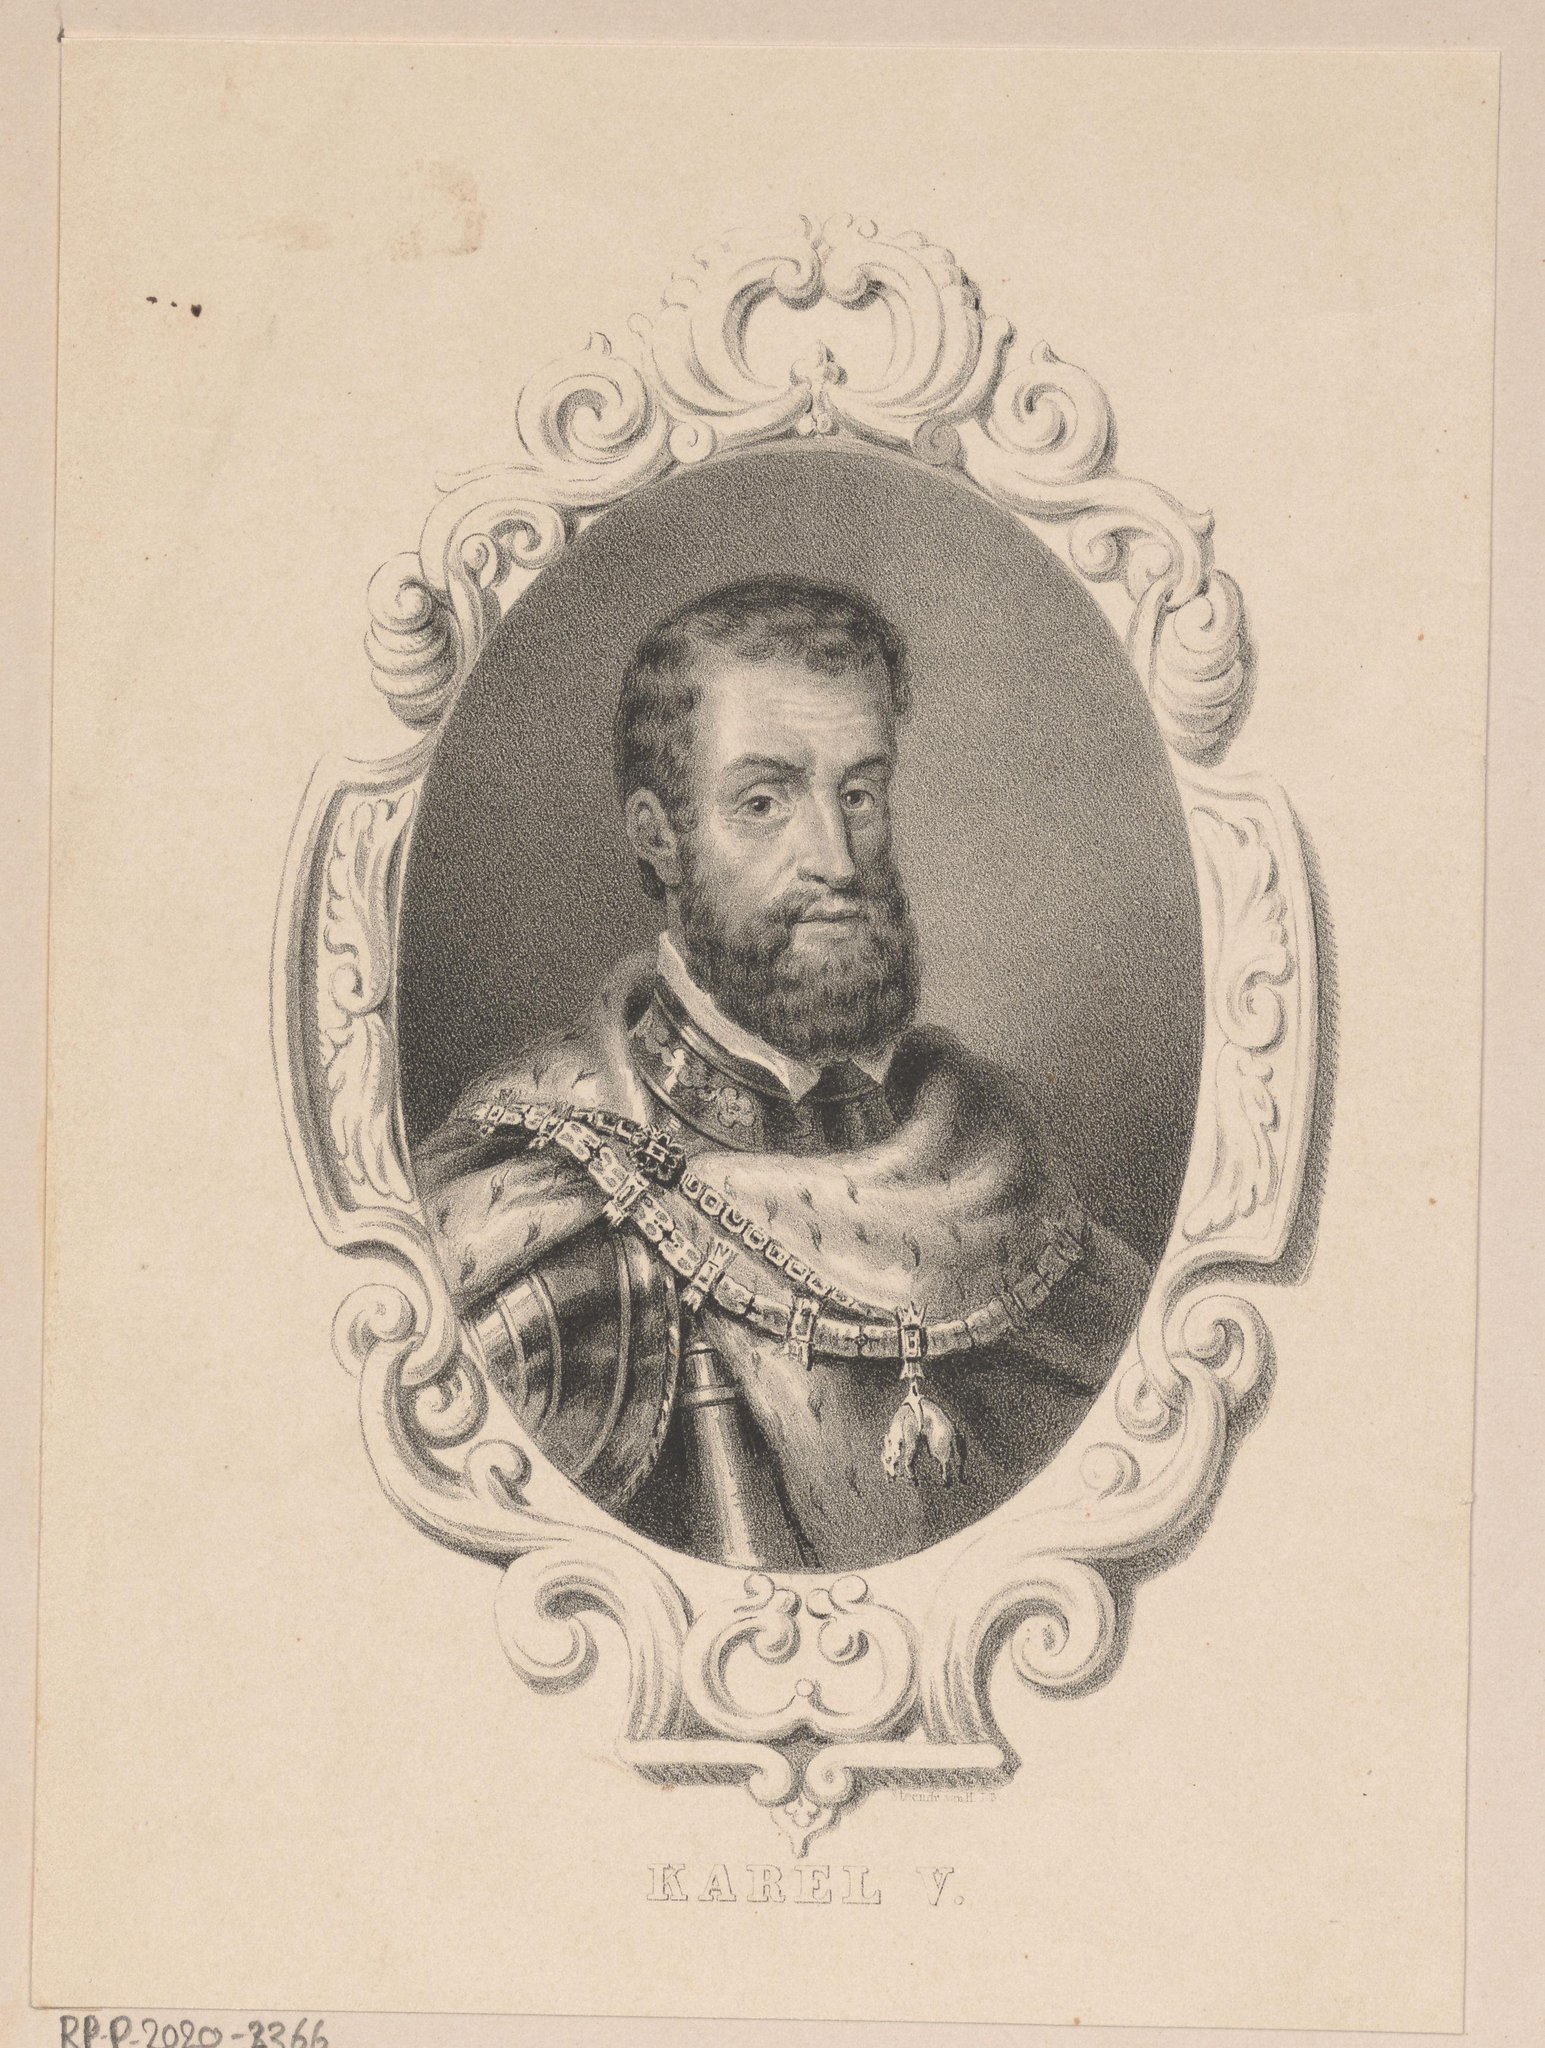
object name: print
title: Portret van keizer Karel V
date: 1822-1845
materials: paper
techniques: lithograph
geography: dordrecht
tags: ghent, charles v (holy roman emperor and king of spain), historical persons, knighthood order of the golden fleece, king